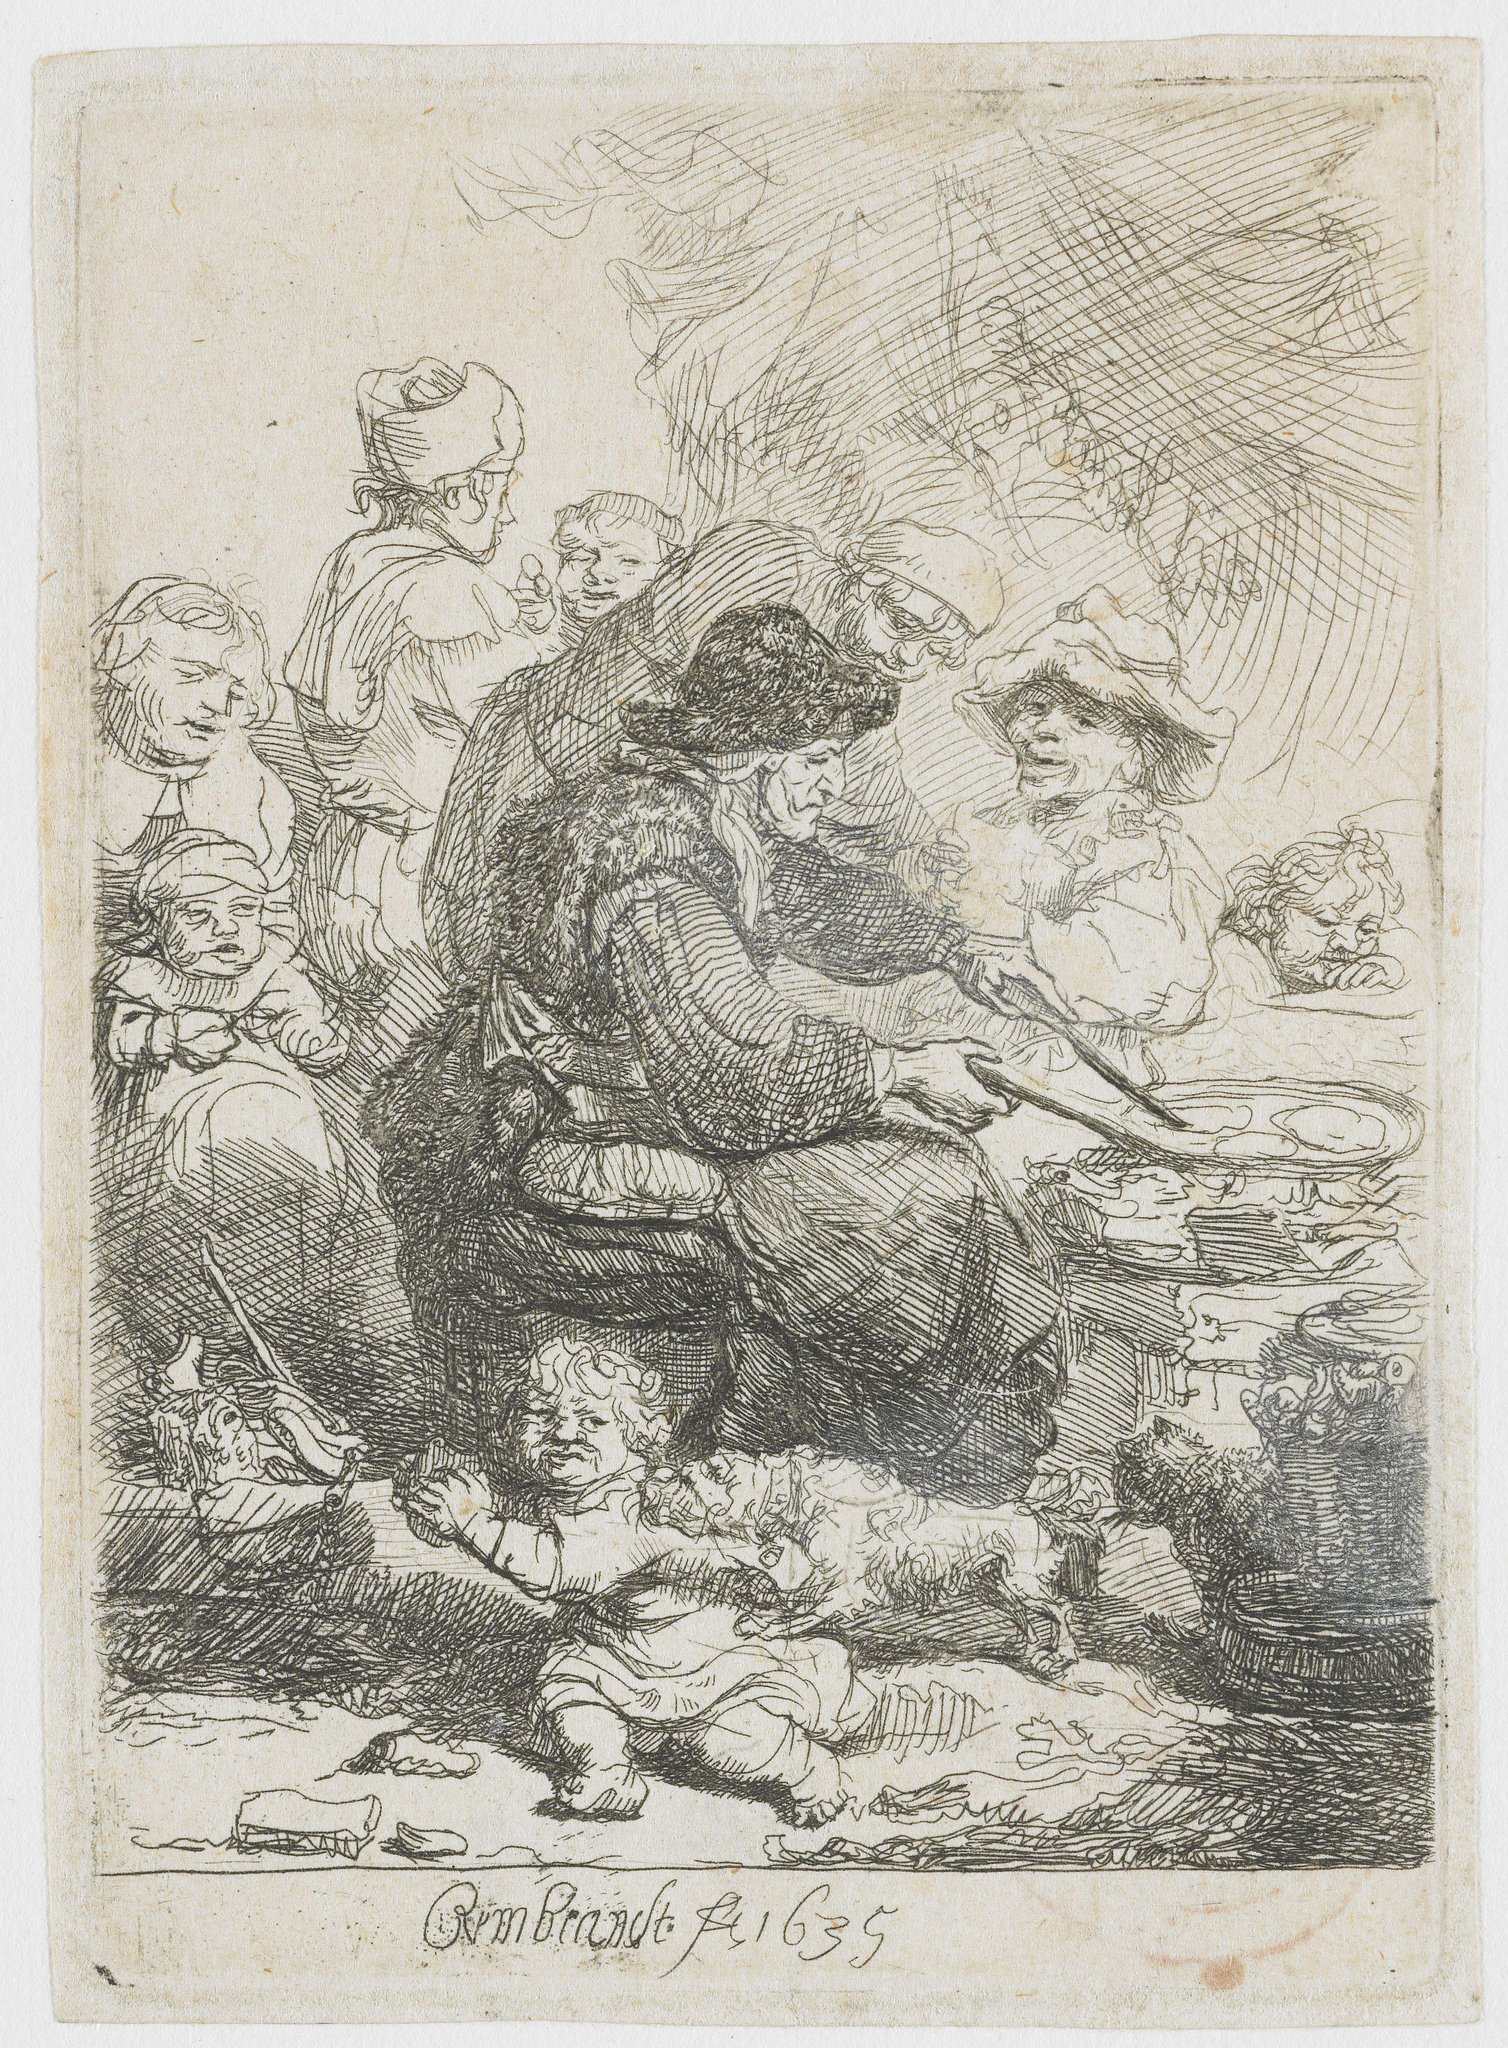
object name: print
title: The pancake woman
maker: rembrandt van rijn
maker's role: draughtsman, painter, print maker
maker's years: 1606-1669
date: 1635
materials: paper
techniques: etching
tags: pancakes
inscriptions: mark: Lugt 240, signature: ‘Rembrandt. f 1635’